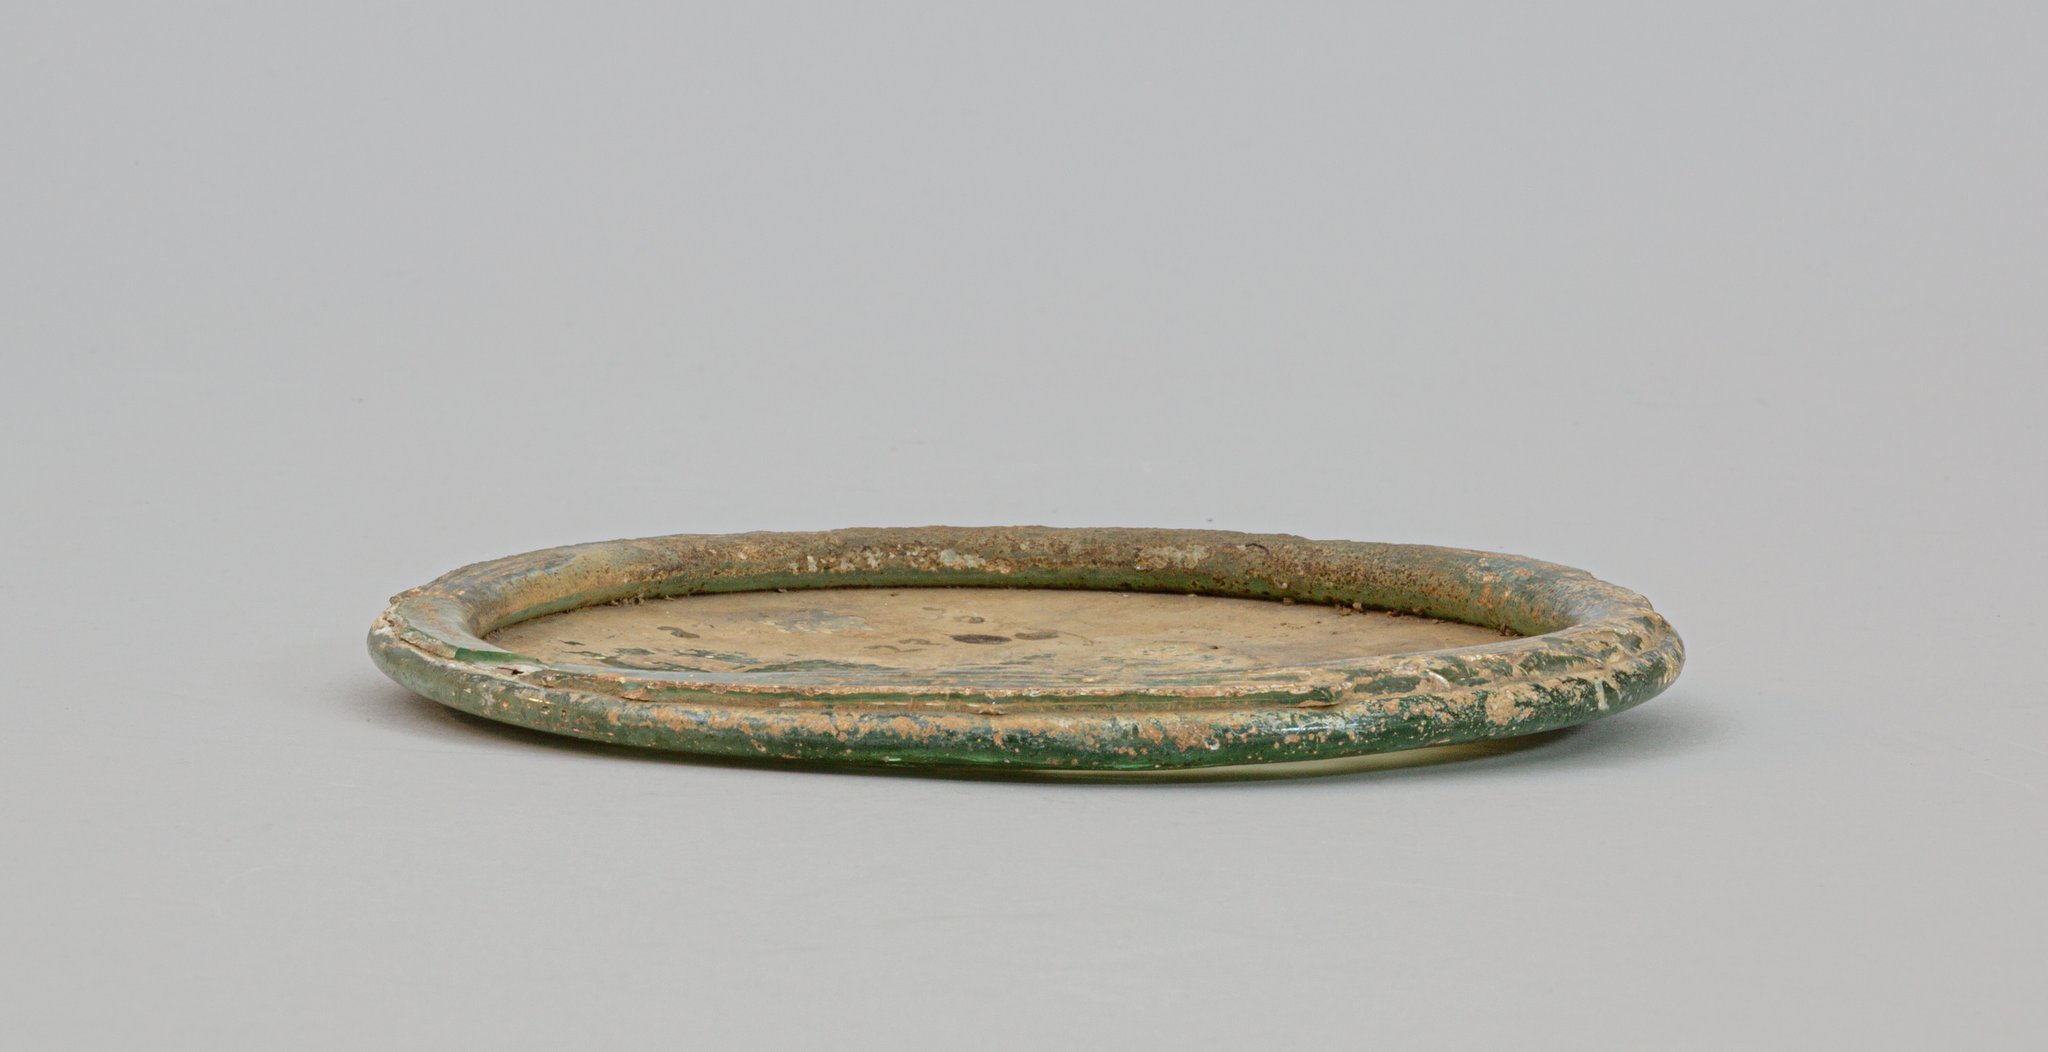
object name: lid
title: Glass lid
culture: roman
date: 1-100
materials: glass